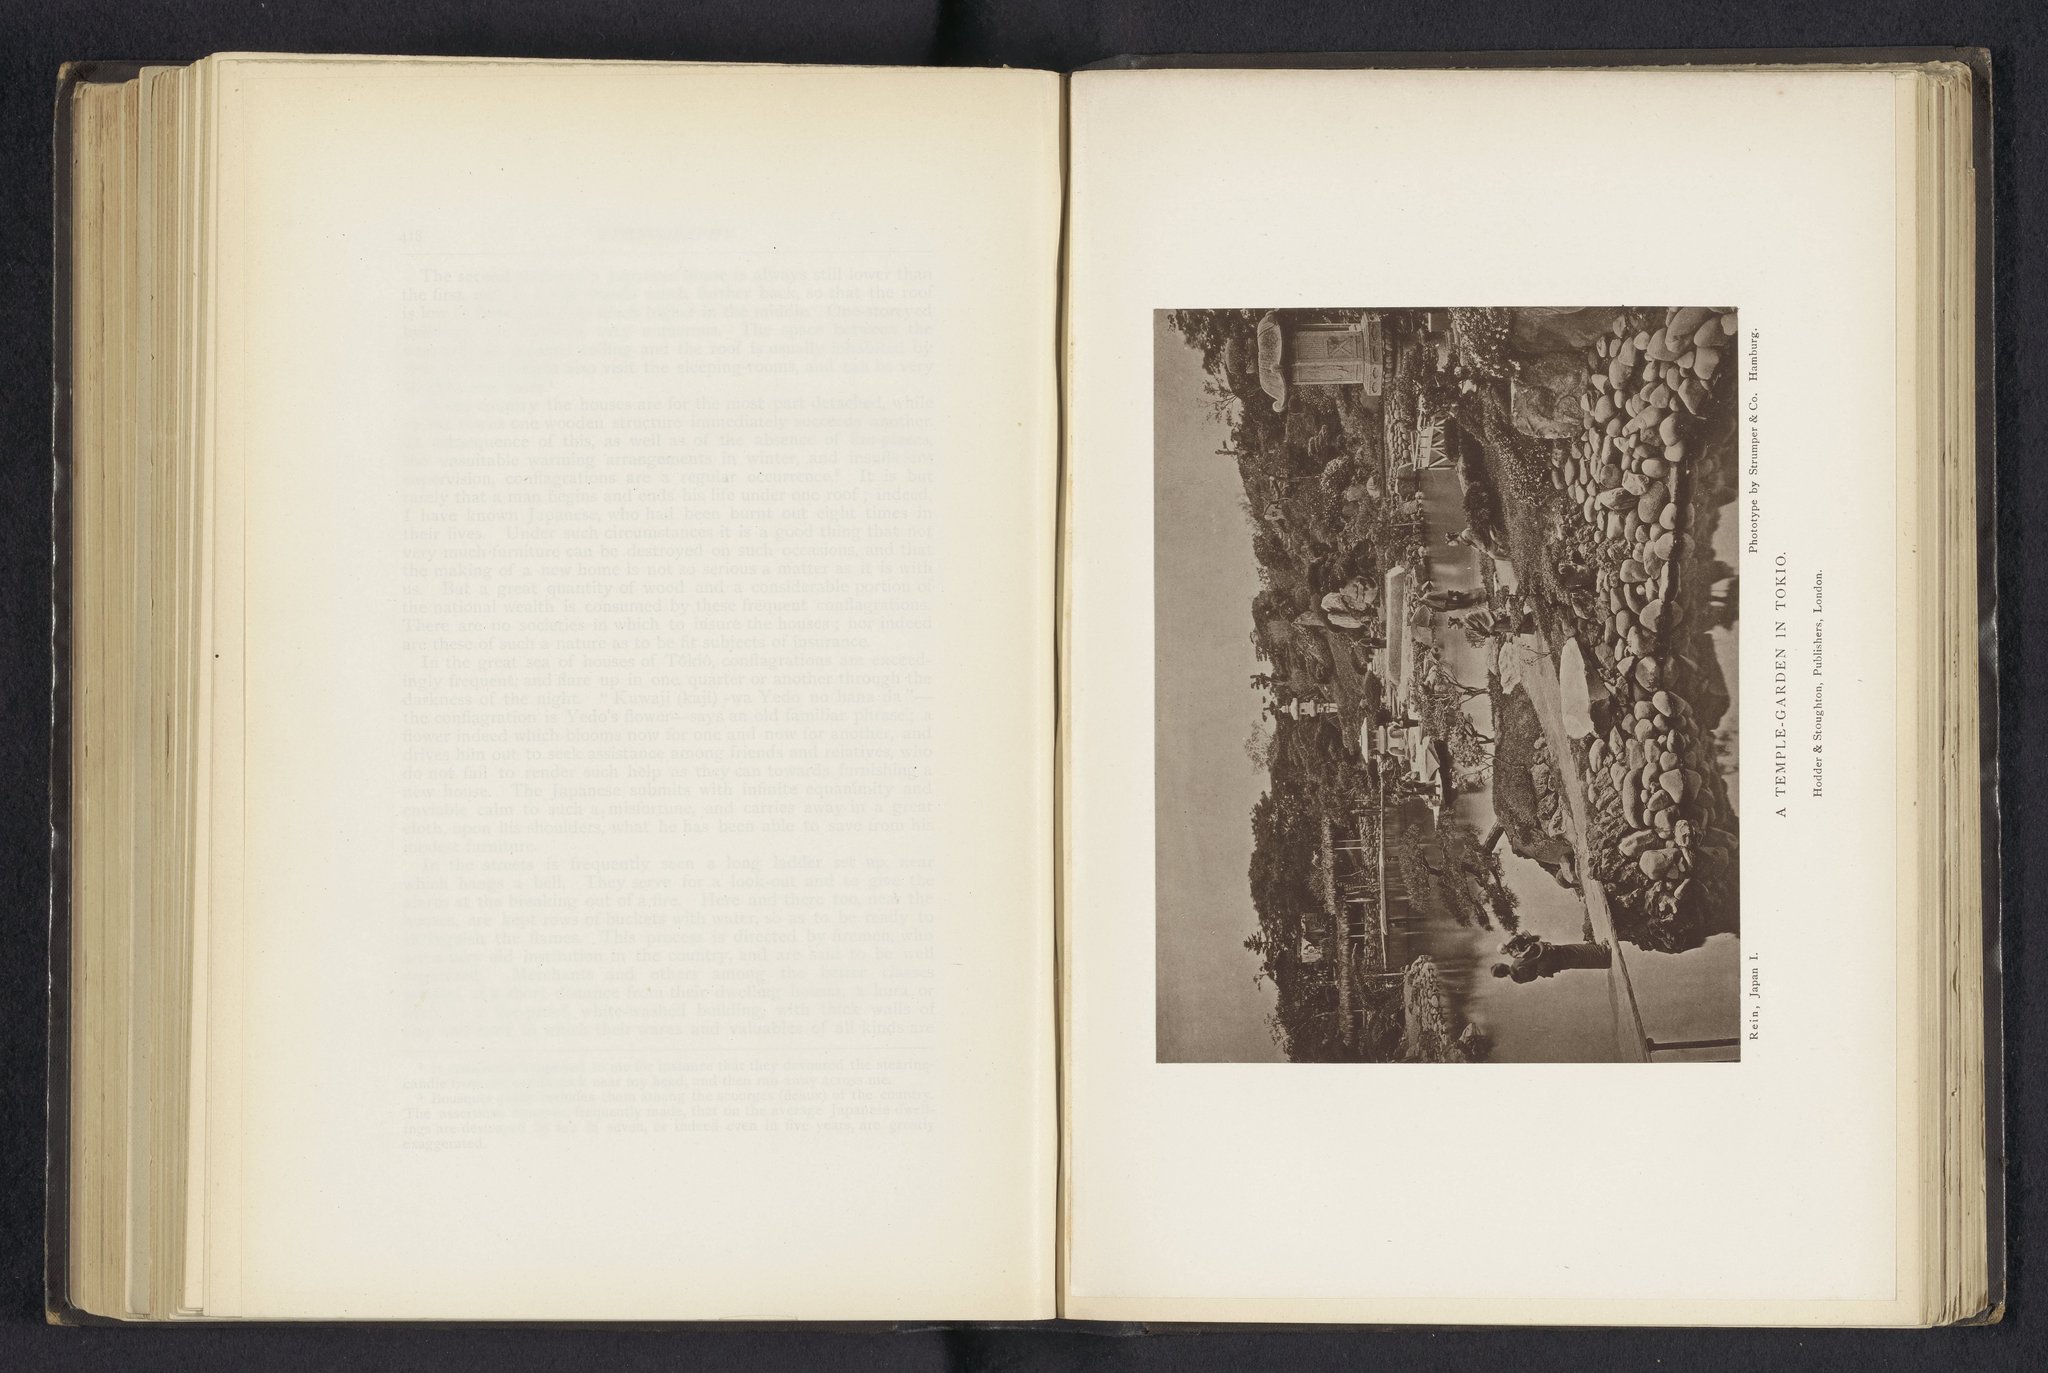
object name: photomechanical print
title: A temple-garden in Tokio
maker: Anonymous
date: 1874-1884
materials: paper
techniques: photograph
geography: london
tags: garden